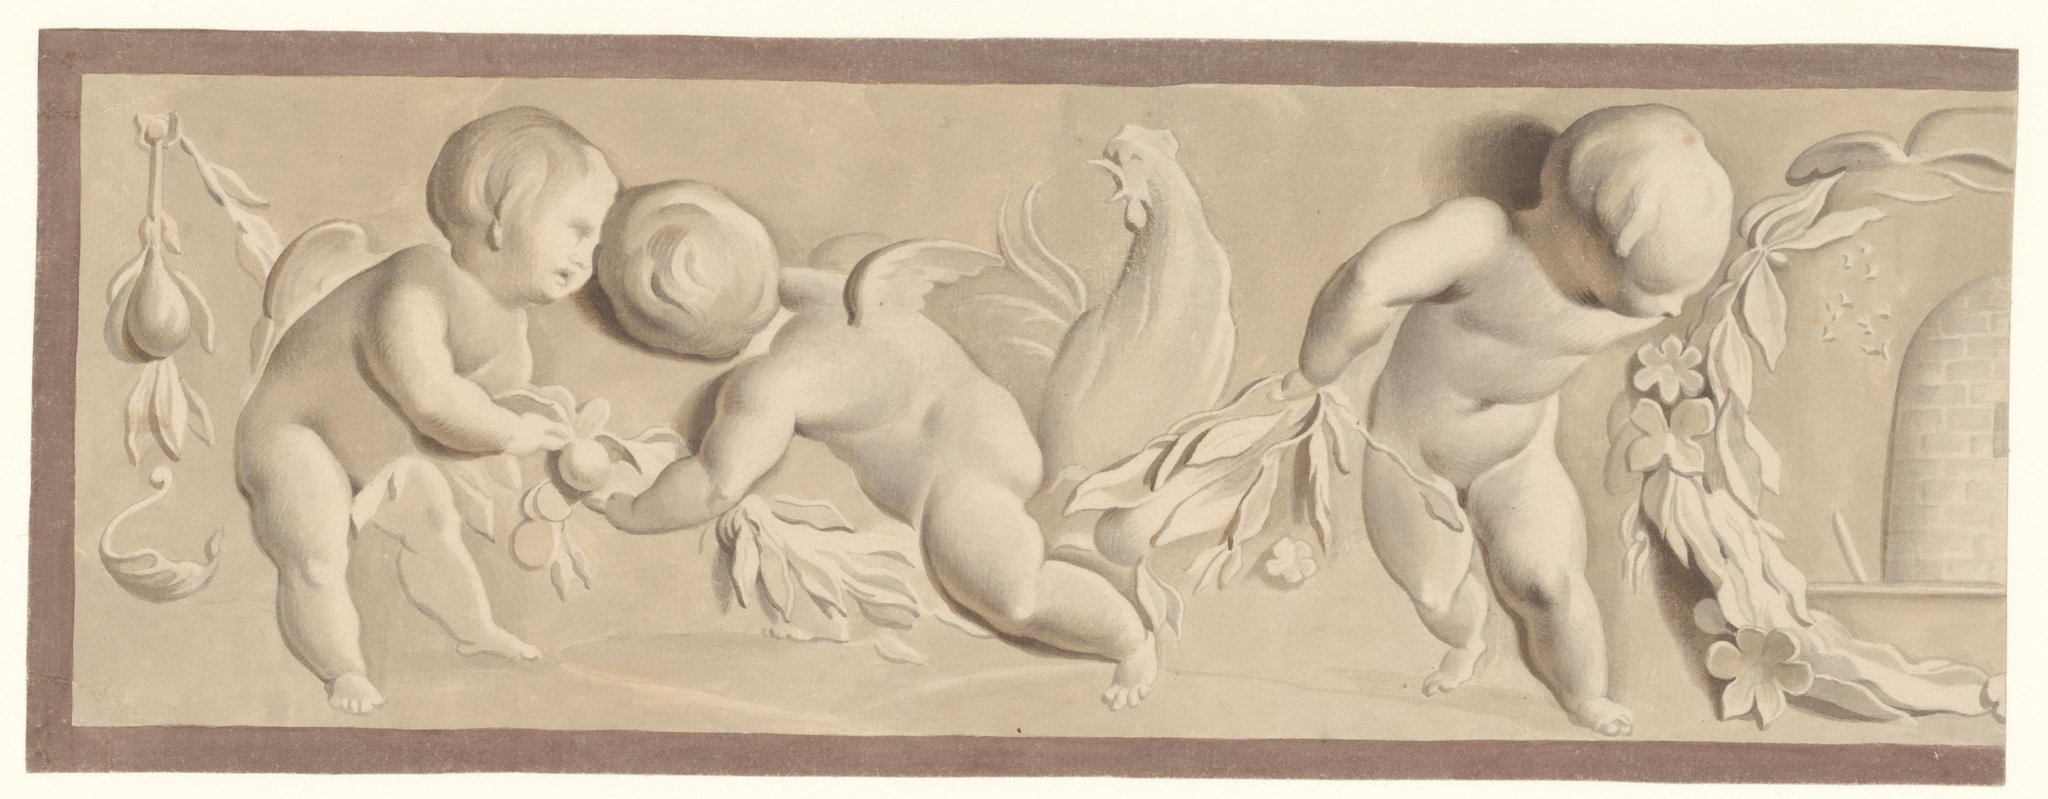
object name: drawing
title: Compositie met drie putti en een haan, rechts een lauwerkrans en een bijenkorf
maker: hendrik pothoven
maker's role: draughtsman, painter, print maker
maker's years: 1725-1807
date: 1735-1807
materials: ink, paper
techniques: brush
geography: amsterdam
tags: cupids together with attributes of the arts, sciences, etc., townhall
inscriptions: inscription: ‘H Pothoven del [...] d Wet berustende op den Raadkamer.’, inscription: ‘Port. 17 - 381a’, collector's mark: ‘17’ Lugt 1641b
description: Onderwerpsrubriek binnen de Atlas Amsterdam: Beeldhouw- en Schilderwerk.